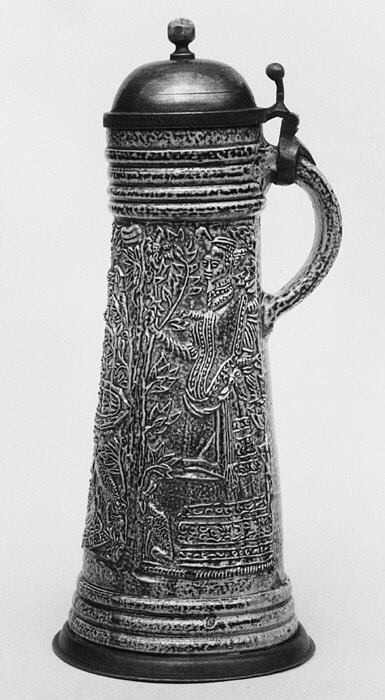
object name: tankard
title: Tankard (Schnelle)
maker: eigelstein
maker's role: maker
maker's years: 1500-1600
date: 1560-1570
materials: pewter, stoneware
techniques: salt glaze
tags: human figures